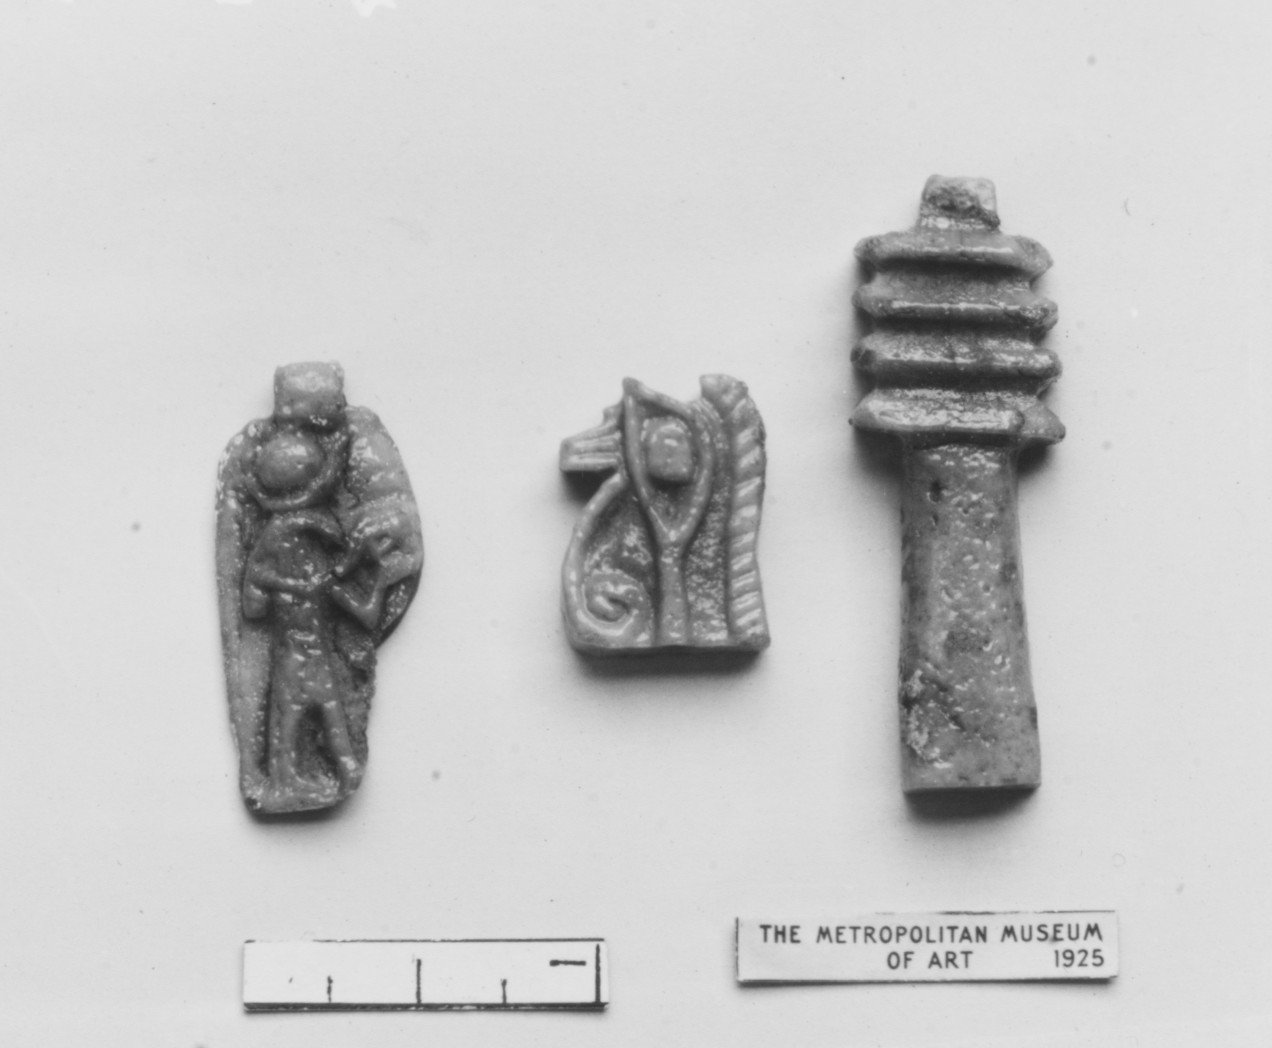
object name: amulet, djedmutesankh, thoth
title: Amulet Plaque with Figure of Thoth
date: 1000-945 BCE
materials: faience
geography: egypt